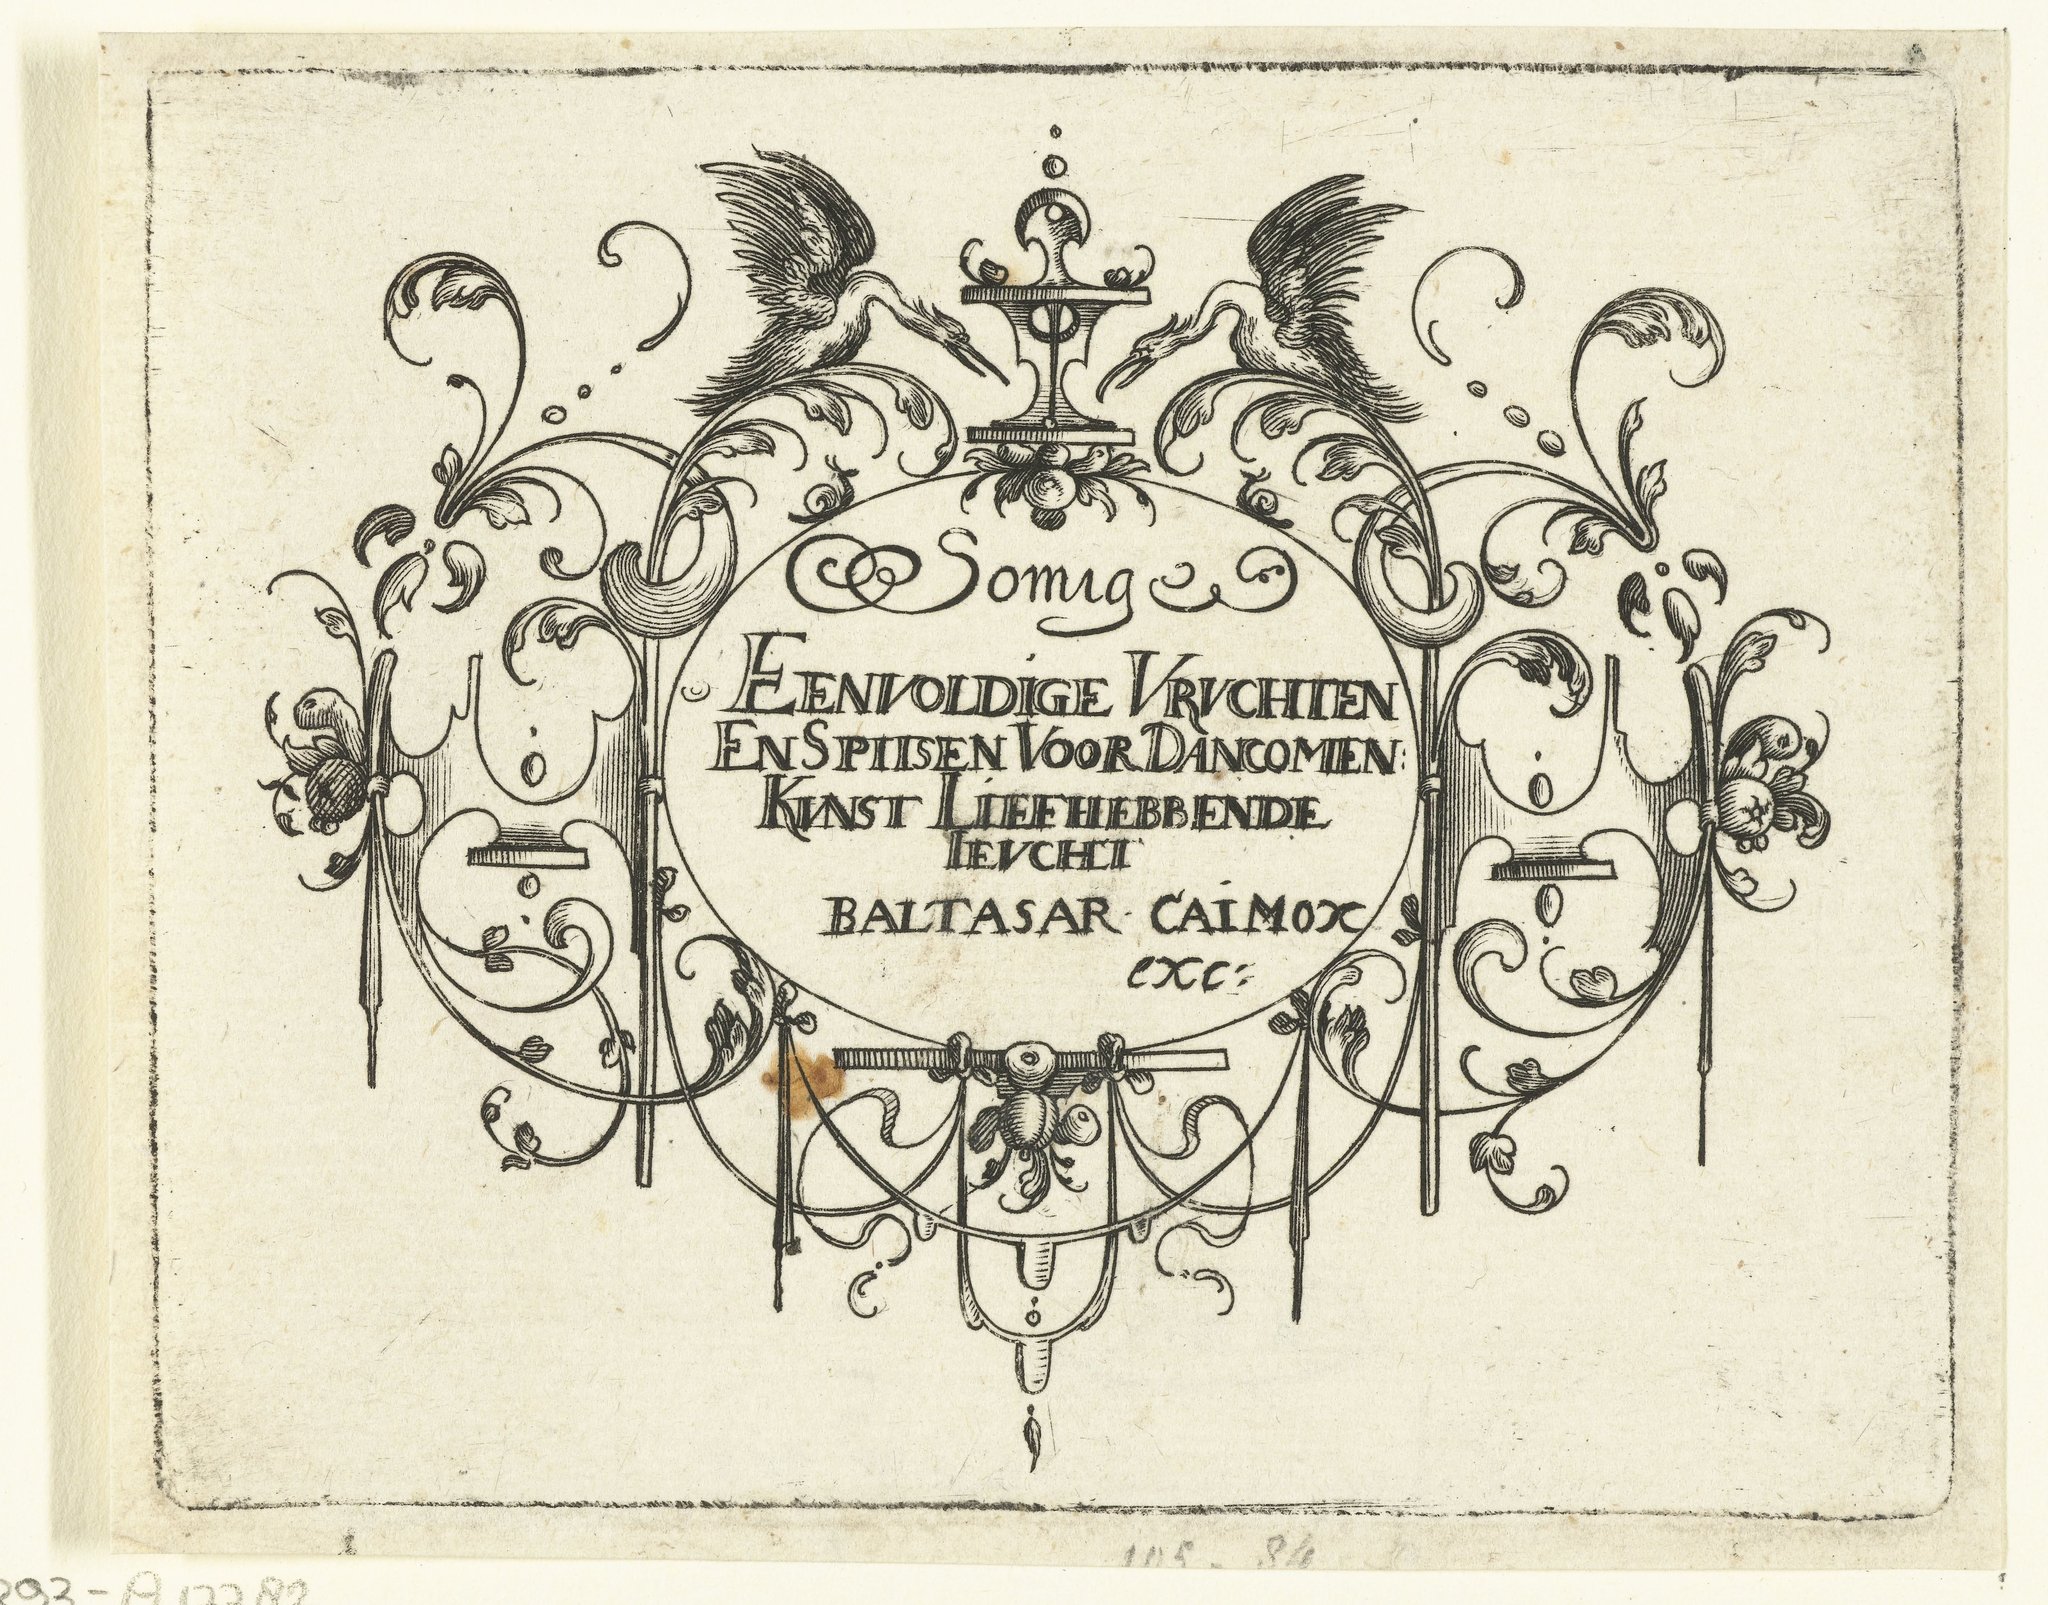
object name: titelprent, frontispice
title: Somige Eenvoldige Vruchten en Spitsen: titelblad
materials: paper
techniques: engraving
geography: nuremberg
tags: scrollwork, strapwork ~ ornament, water-birds: swan, ornament ~ cartouche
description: Cartouche van rolwerk met twee zwanen bovenaan. Ovaal schild in het midden waarop de tekst van de titel. Kopie van serie met dezelfde titel, uitgegeven door Michiel le Blon. Titelblad uit serie van 14 bladen met voorbeelden voor gegraveerde decoratieranden van bekers in de vorm van driehoeken bestaande uit ranken, Schweifwerk, guirlandes met putti, dieren, vogels en maskers.